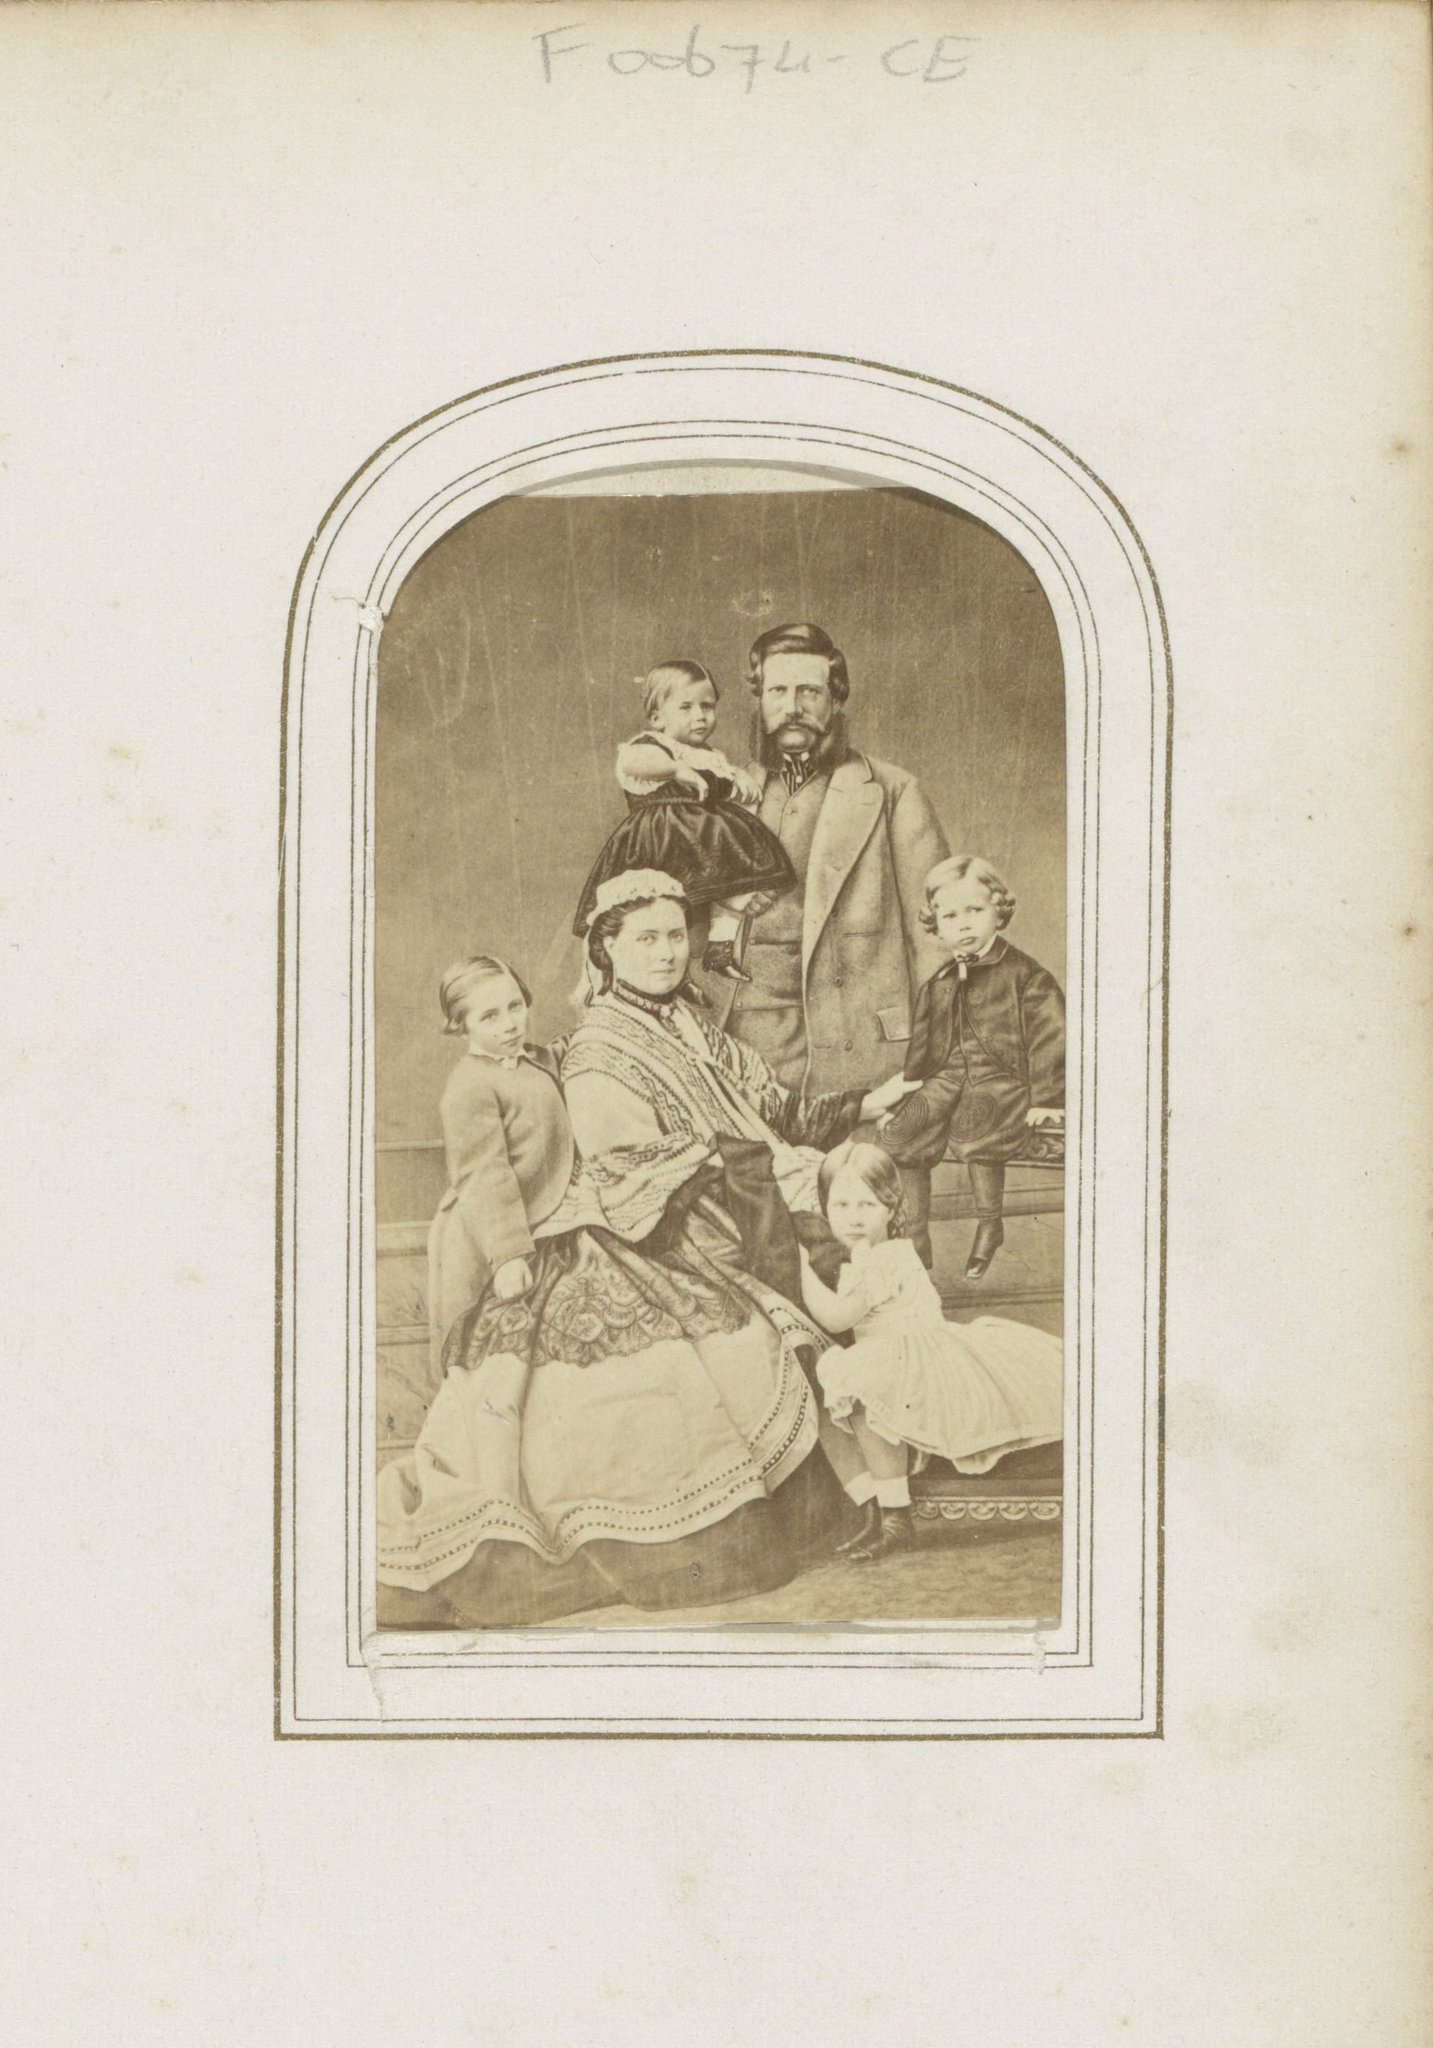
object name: photograph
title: Groepsportret van het gezin van Friedrich Wilhelm, kroonprins van Pruisen, met links Wilhelm (de latere keizer Wilhelm II)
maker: Anonymous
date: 1864-1867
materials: cardboard, paper, photographic support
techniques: albumen print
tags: wilhelm ii (keizer van duitsland), family group, especially parents with their child(ren), prince, historical persons, ruler, sovereign, dress, gown, crown prince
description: Onderdeel van Fotoalbum met 123 cartes-de-visite van leden van Europese vorstenhuizen, politici en bekende personen.